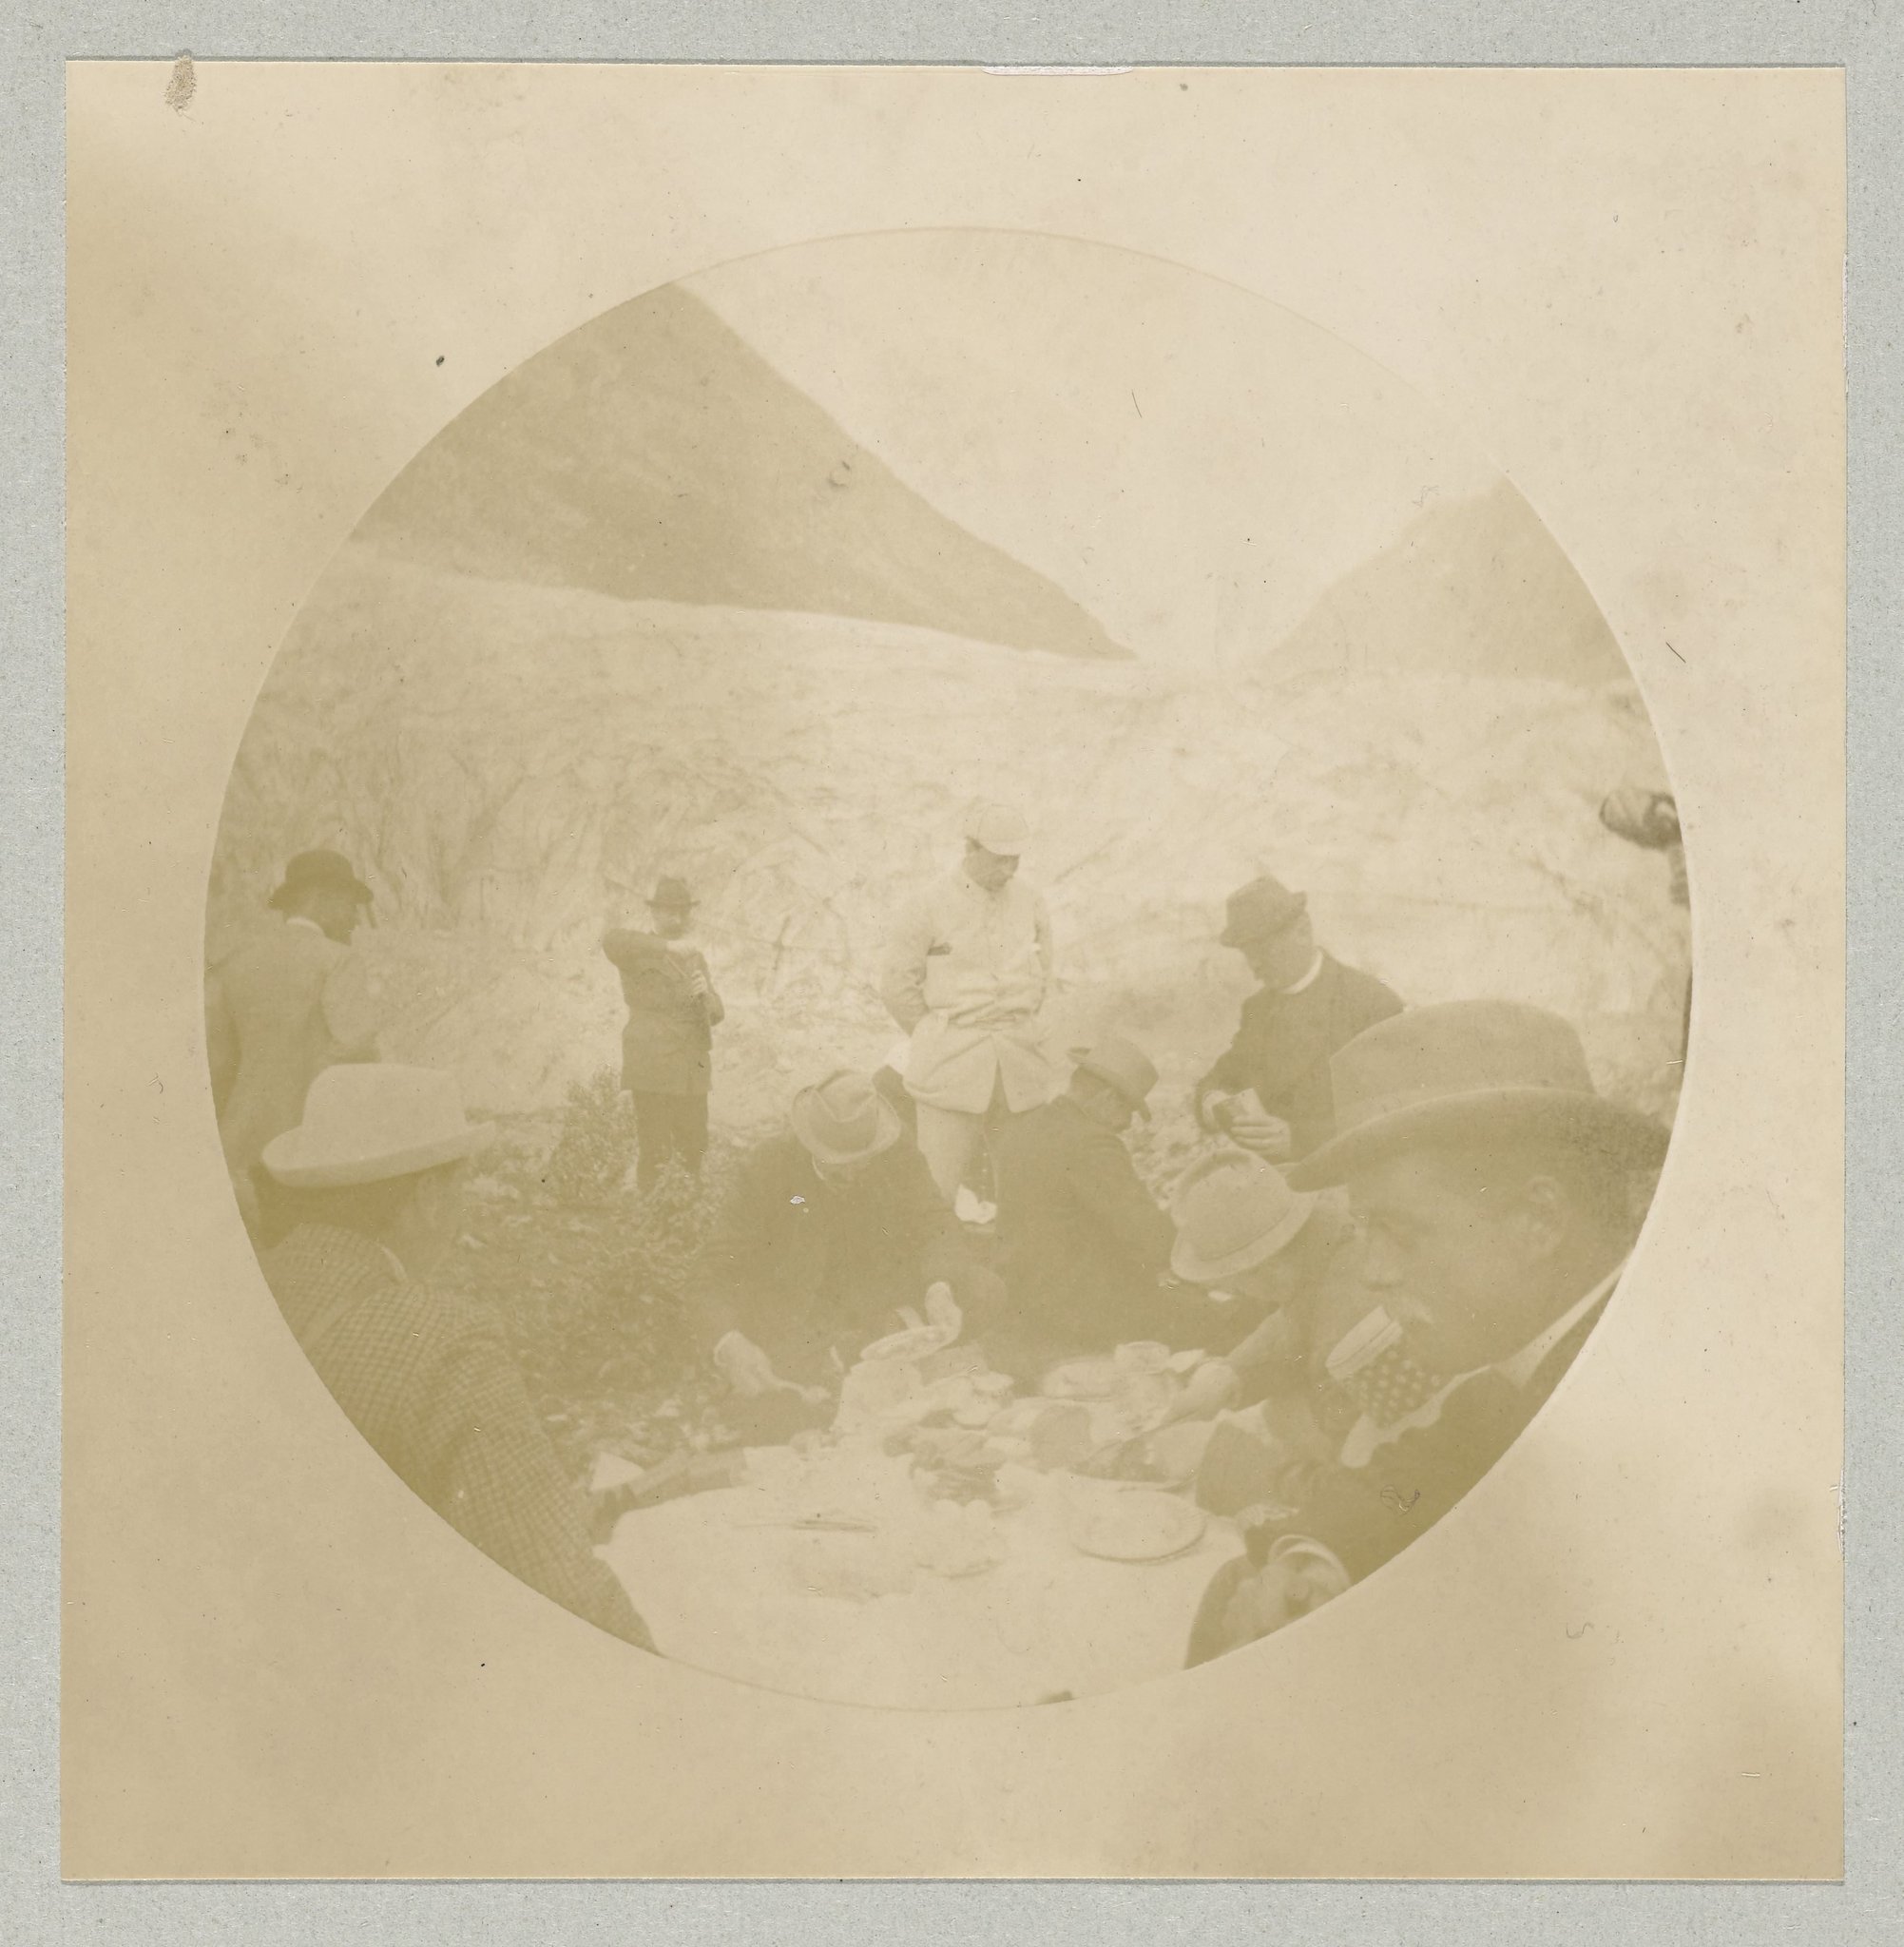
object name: photograph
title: Het gezelschap van Keizer Wilhelm II in het gedeeltelijk met sneeuw bedekte Noorse berglandschap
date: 1807-1889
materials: cardboard, paper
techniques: gelatin silver print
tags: wilhelm ii (keizer van duitsland), norway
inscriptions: number: ‘18’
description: De afdruk van de foto is rond, het papier vierkant. foto gemaakt met Nr. 1 Kodak Camera